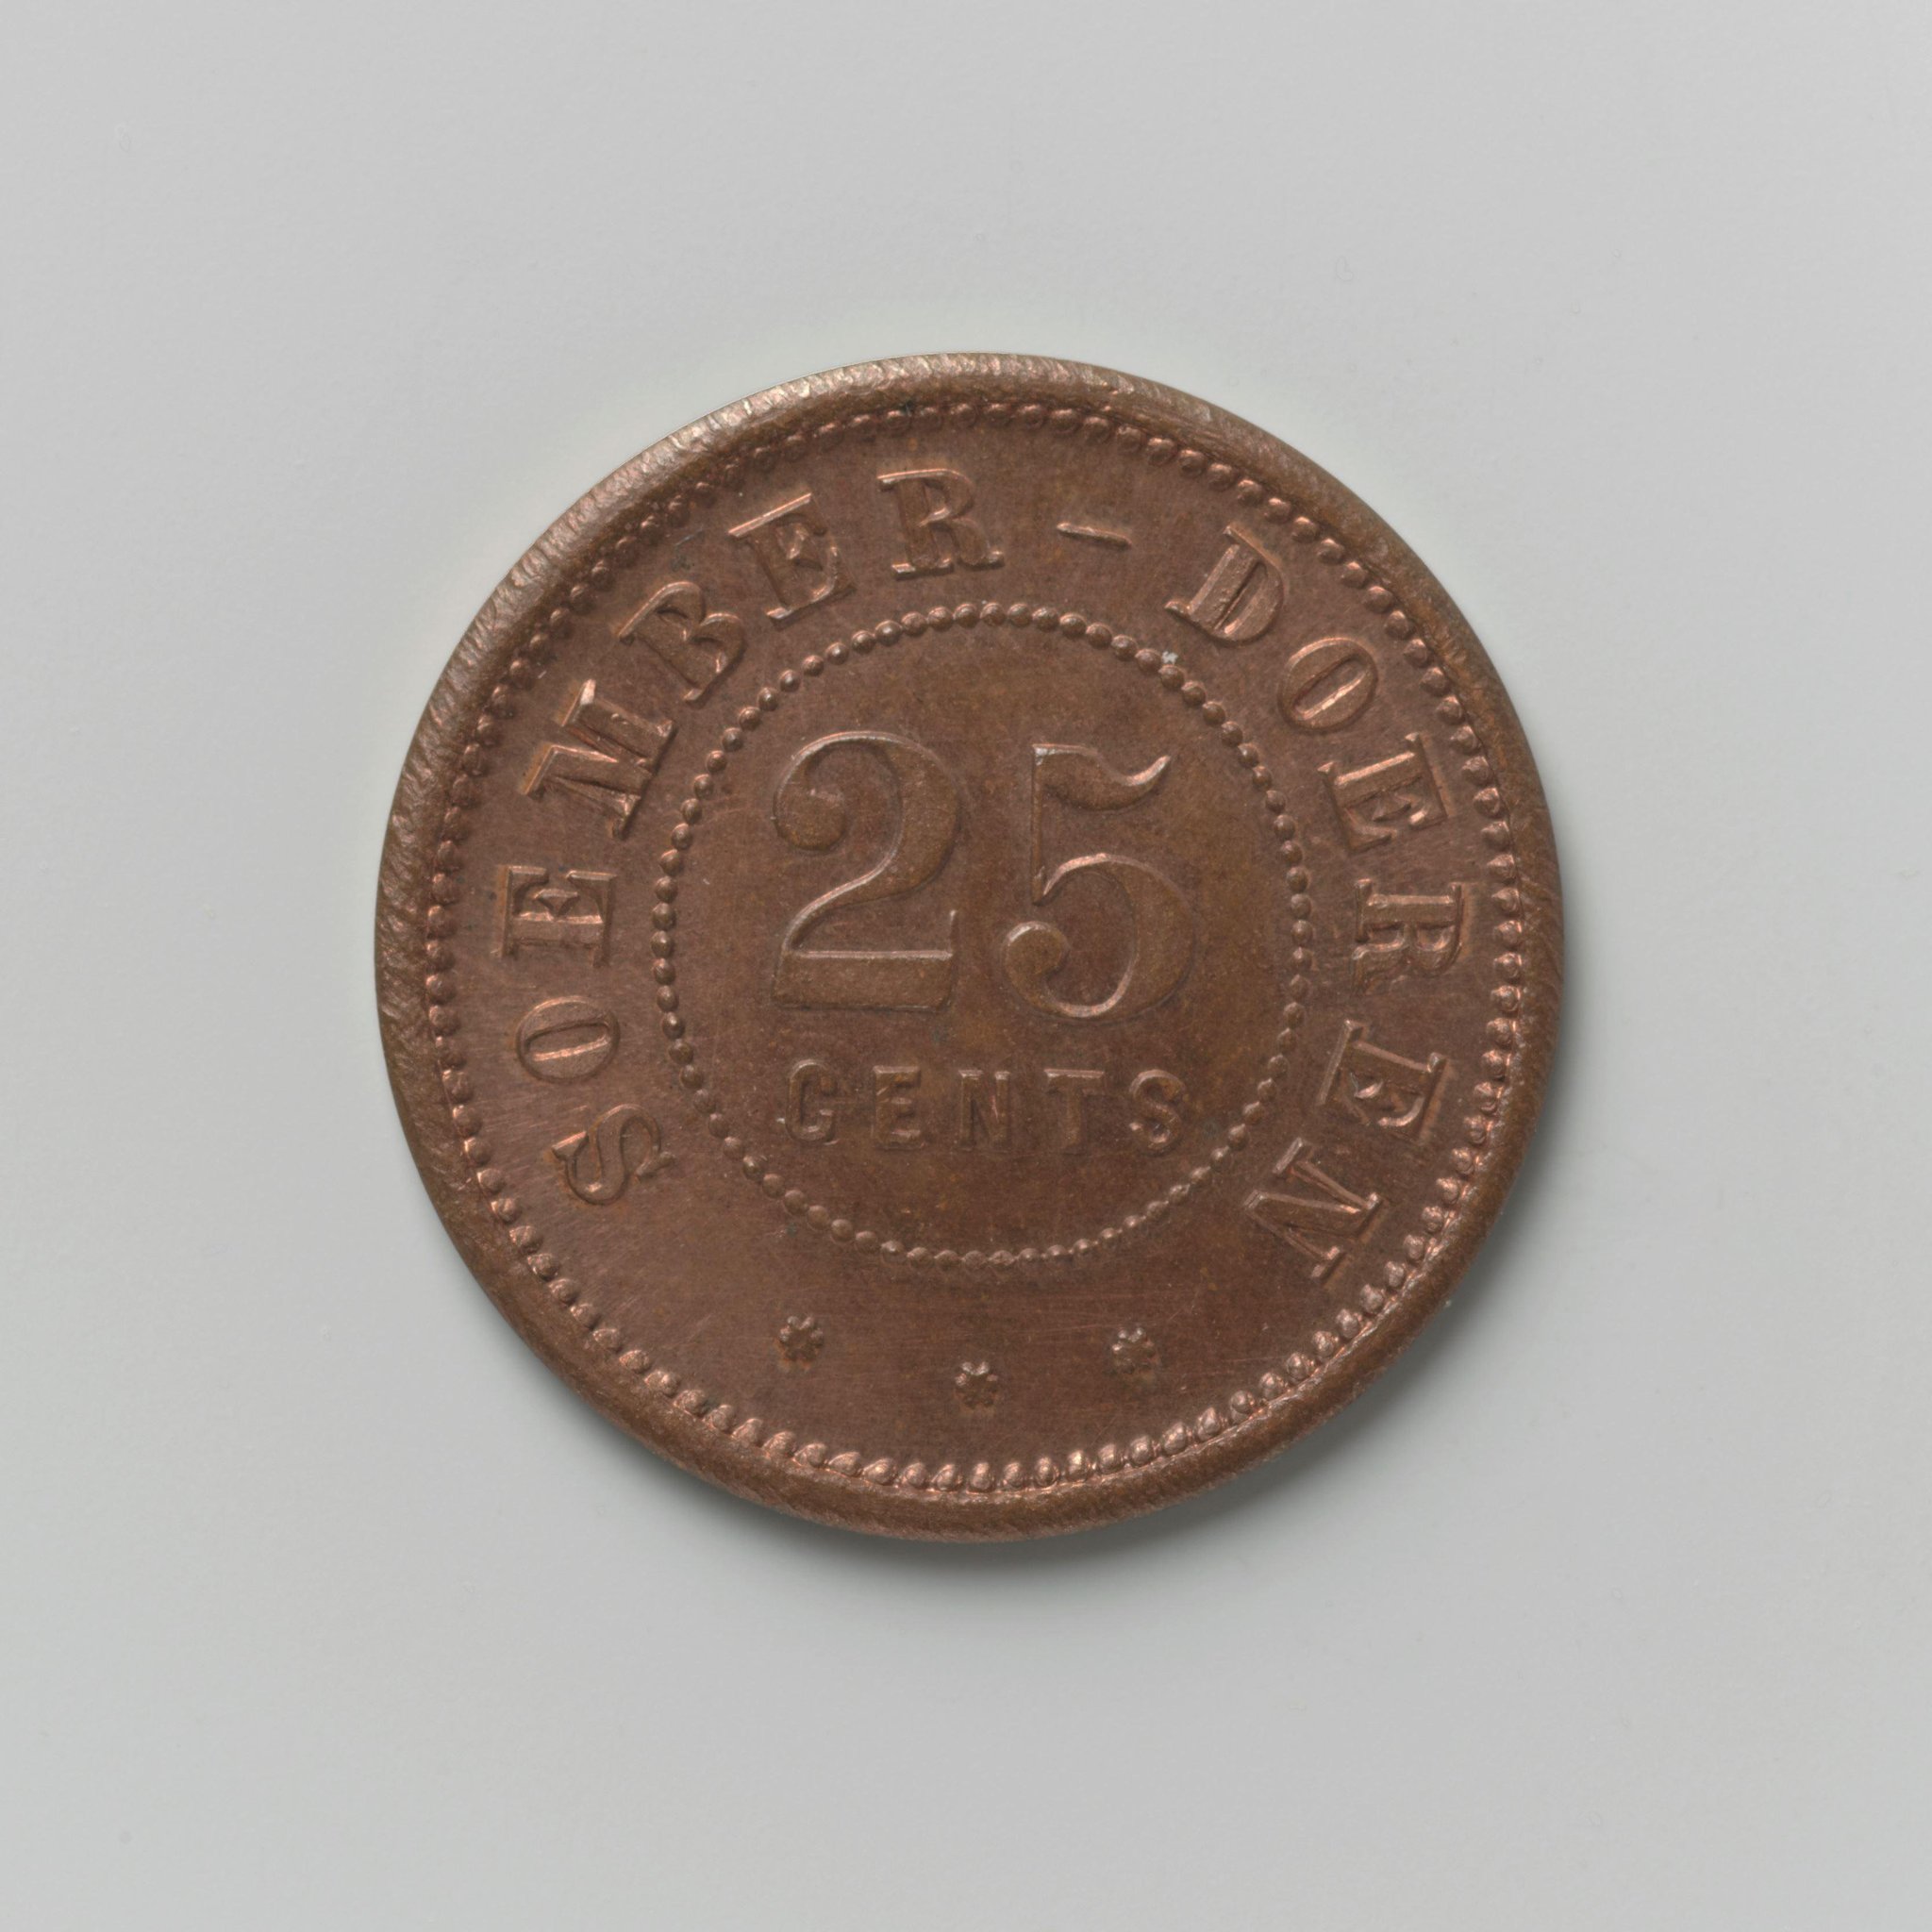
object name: bar money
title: Plantage Soember Boeren, 25 cents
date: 1875-1925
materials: copper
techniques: striking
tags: plantage soember-doeren, passoeroean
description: Koperen partuculiere munt. Plantage-geld. Voorzijde: in twee regels waarde-aanduiding. In omschrift aanduiding van de plantage. Keerzijde: in twee regels waarde-aanduiding. Gladde rand.